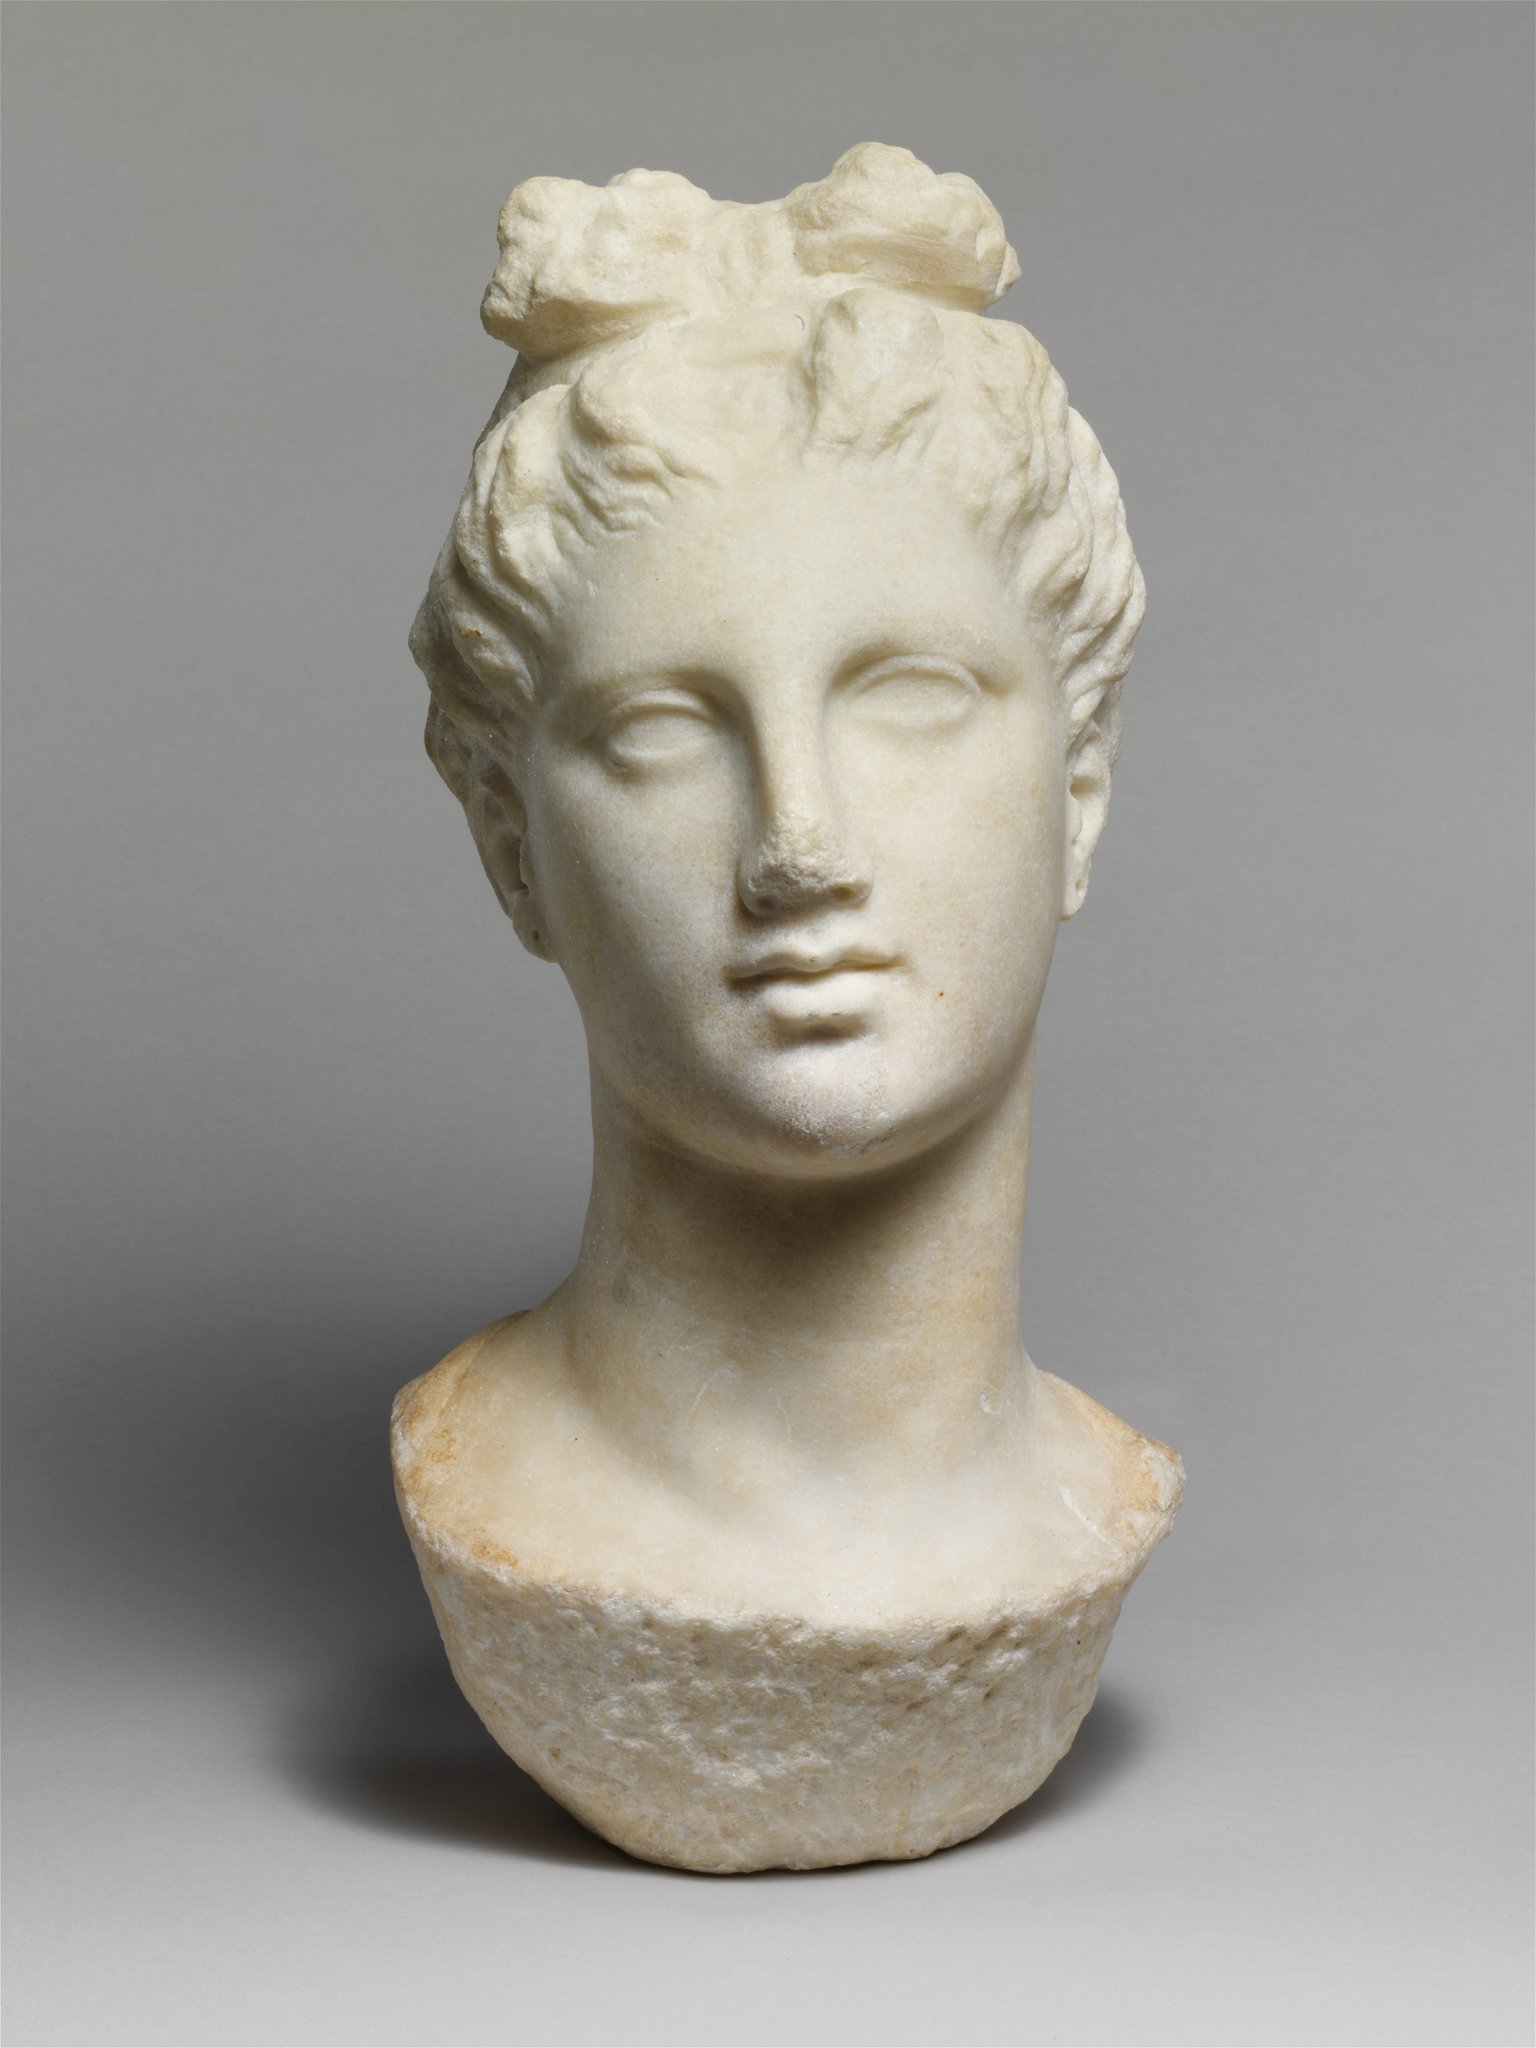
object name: head of a woman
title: Marble head of a young woman from a funerary statue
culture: greek, attic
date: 334-301 BCE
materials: marble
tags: heads,women